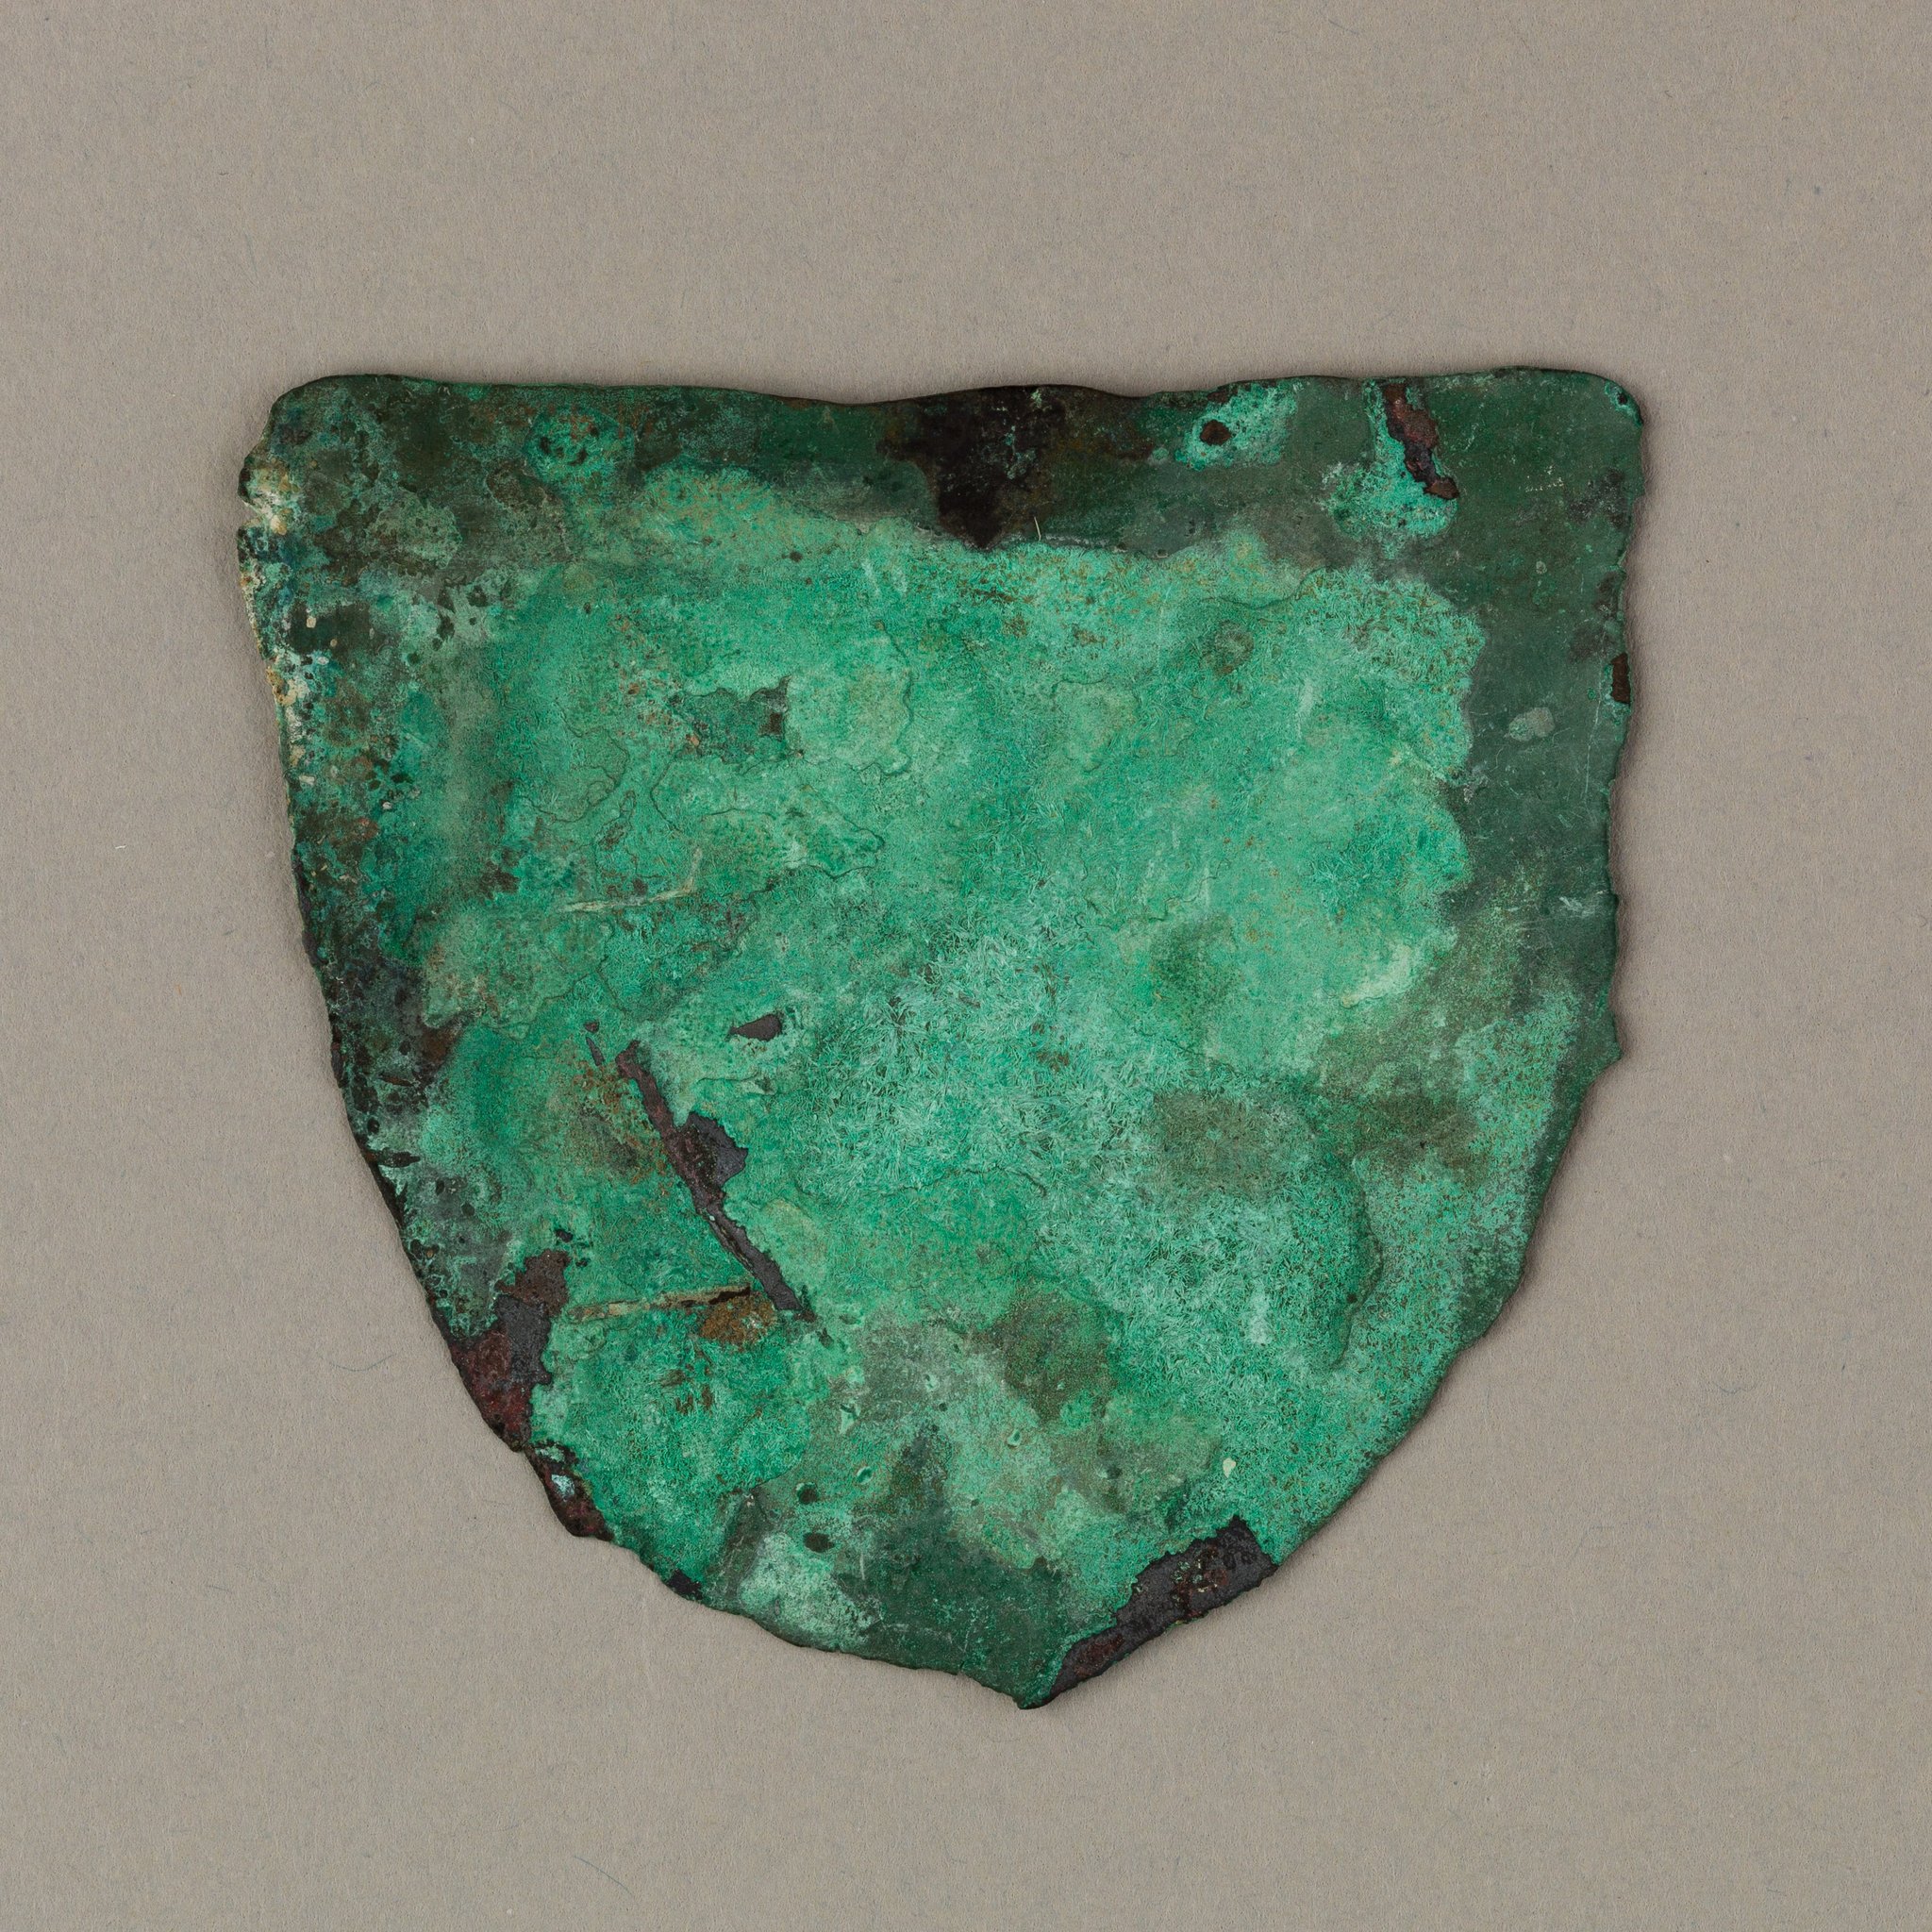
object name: model ax head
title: Model ax-head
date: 2650 BCE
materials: copper alloy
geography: egypt